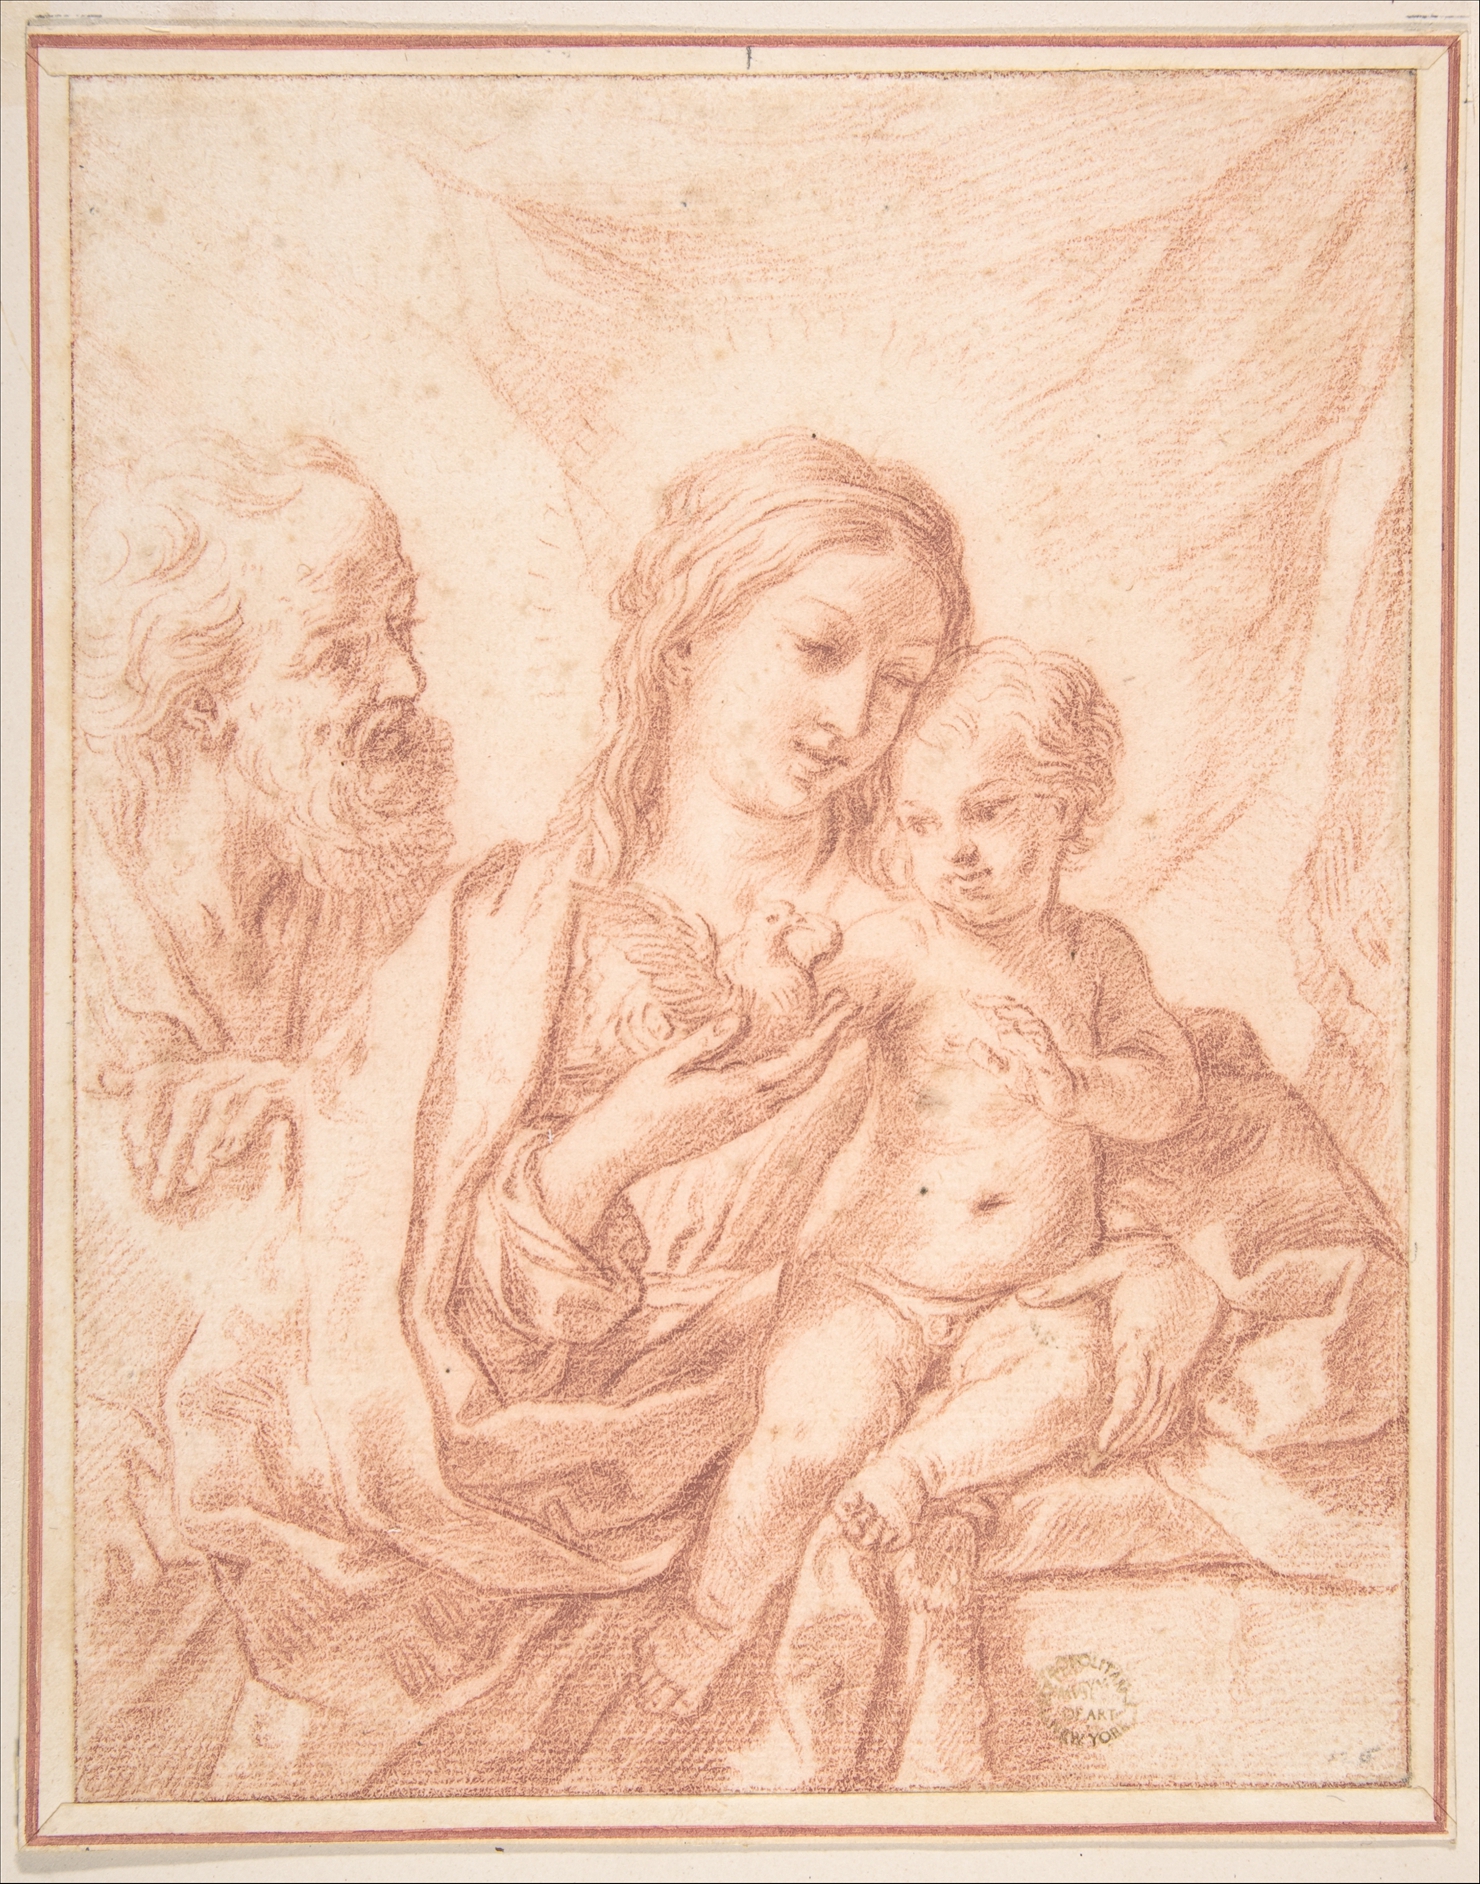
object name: drawing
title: Holy Family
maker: anonymous, italian, roman-bolognese, 17th century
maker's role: artist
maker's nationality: italian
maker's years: 1600-1700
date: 1601-1700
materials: chalk, paper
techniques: incising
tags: holy family